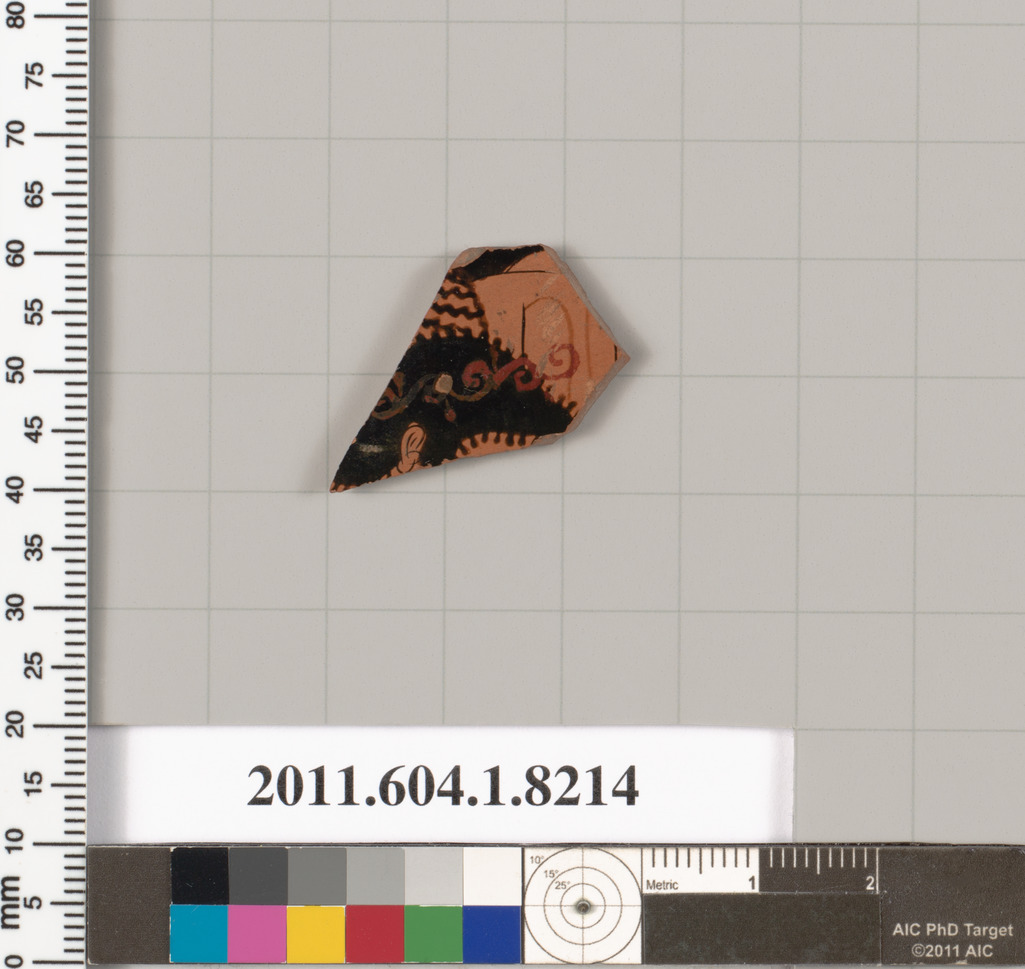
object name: kylix fragment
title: Terracotta fragment of a kylix (drinking cup)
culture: greek, attic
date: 534-501 BCE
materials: terracotta